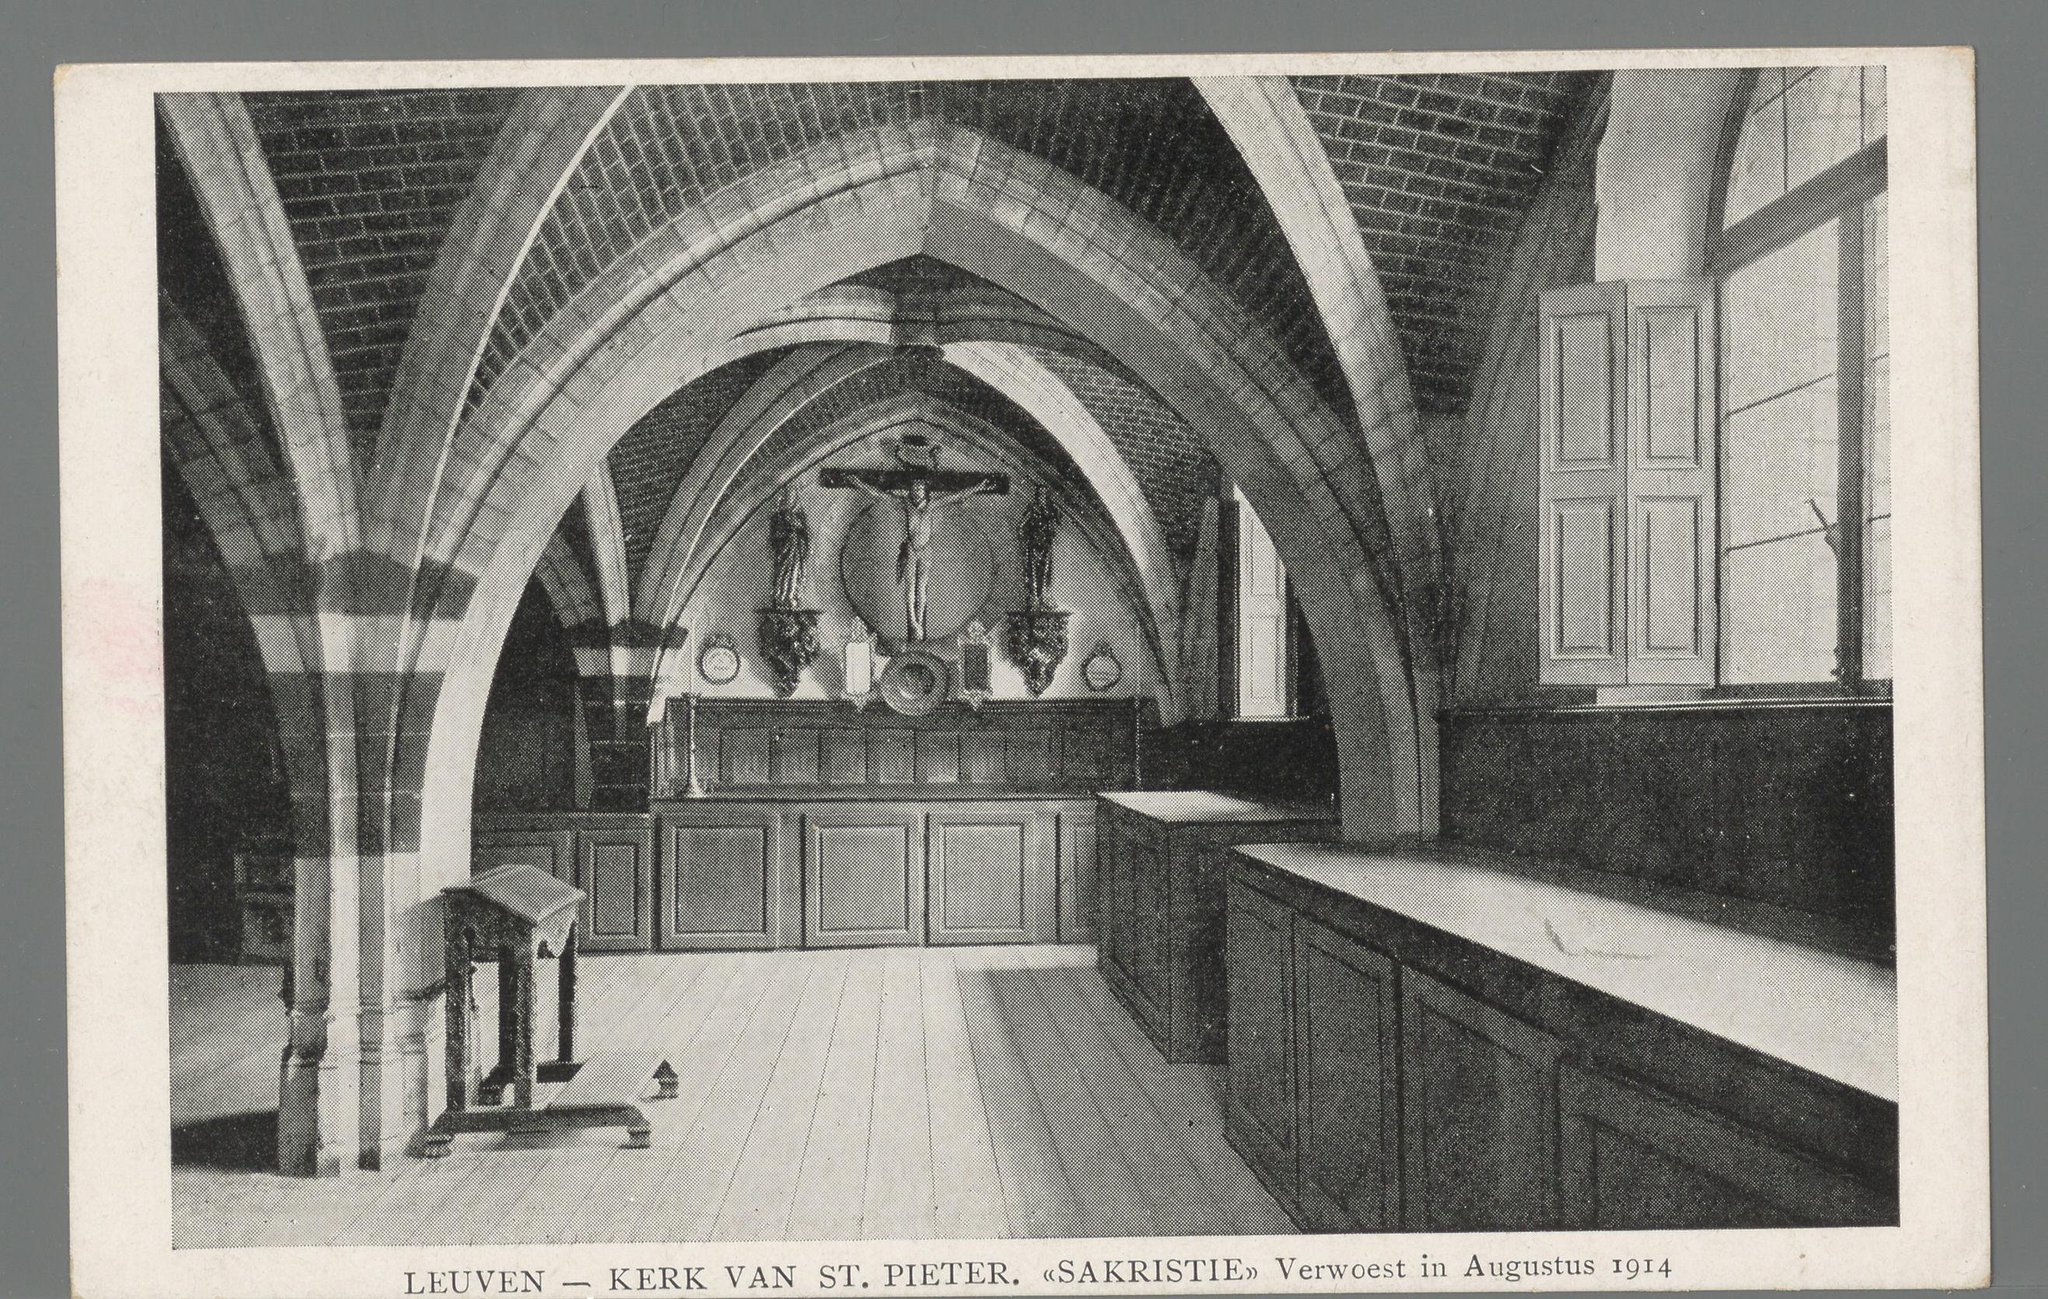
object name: ansichtkaart, prentbriefkaart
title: Leuven. Kerk van St. Pieter. "Sakristie". Verwoest in Augustus 1914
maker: Anonymous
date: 1914-1930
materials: cardboard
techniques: autotype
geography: leuven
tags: parts of church interior: sacristy